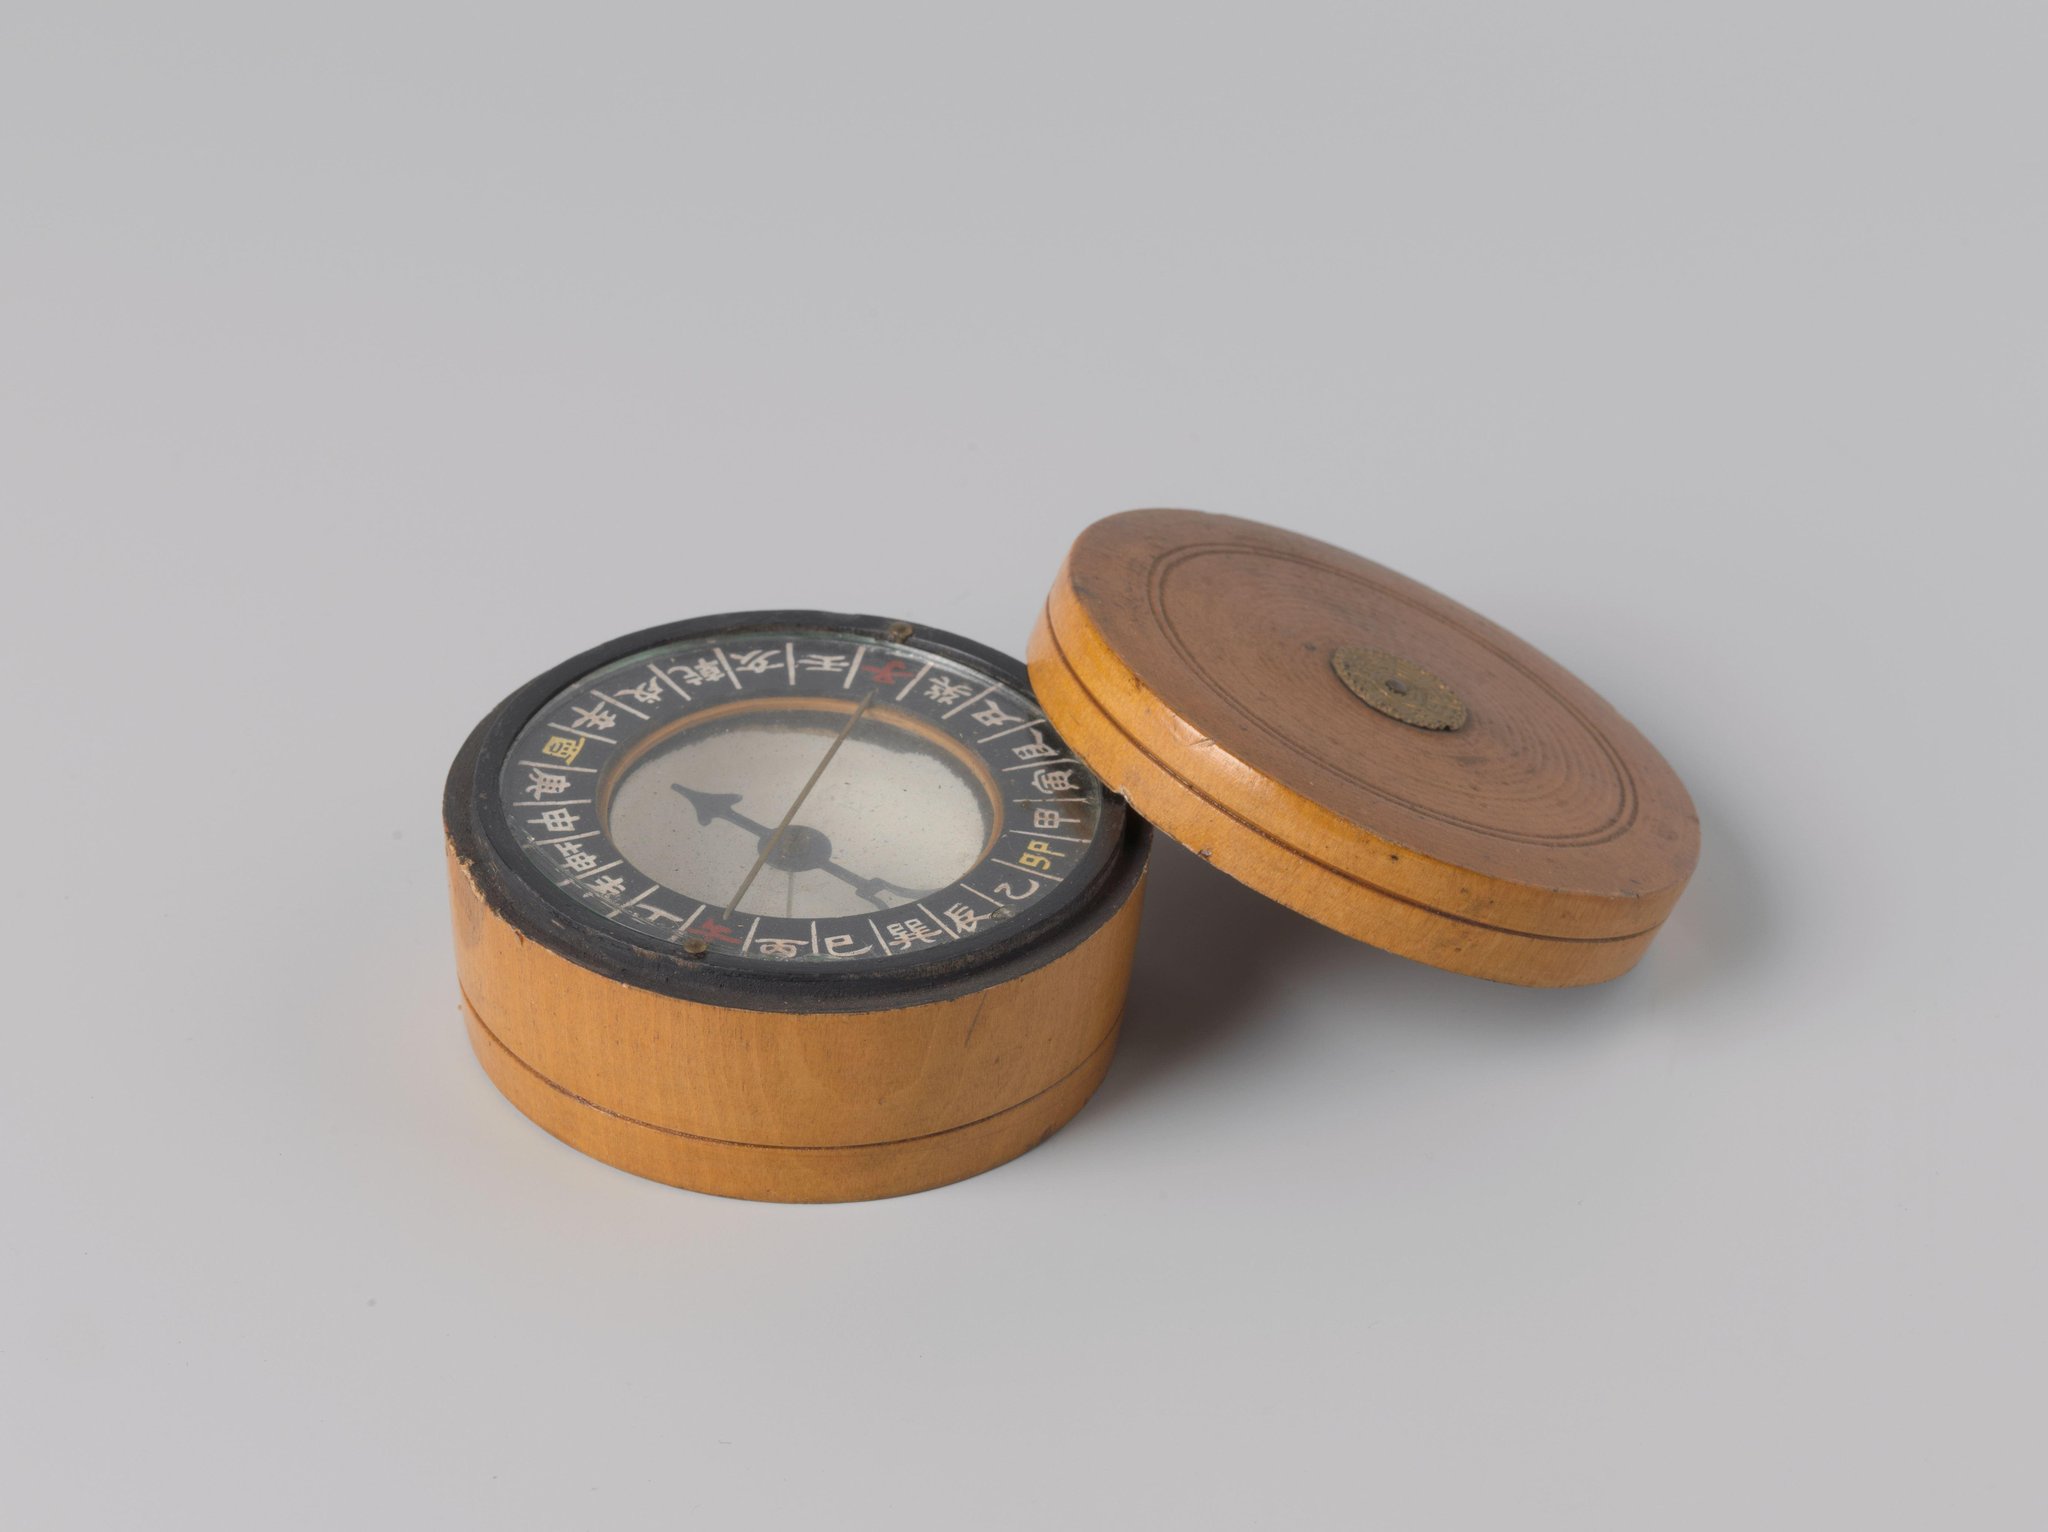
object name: lid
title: Chinese Compass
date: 1850-1899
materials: wood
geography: yantai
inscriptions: inscription: ‘MADE BY/ Pae Sze Co./ CHEFOO’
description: Houten deksel van een Chinees kompas. Aan de binnenzijde van het deksel is een stempel met daarop de naam van de maker Pae Sze Co. uit Chefoo, het huidige Yantai.